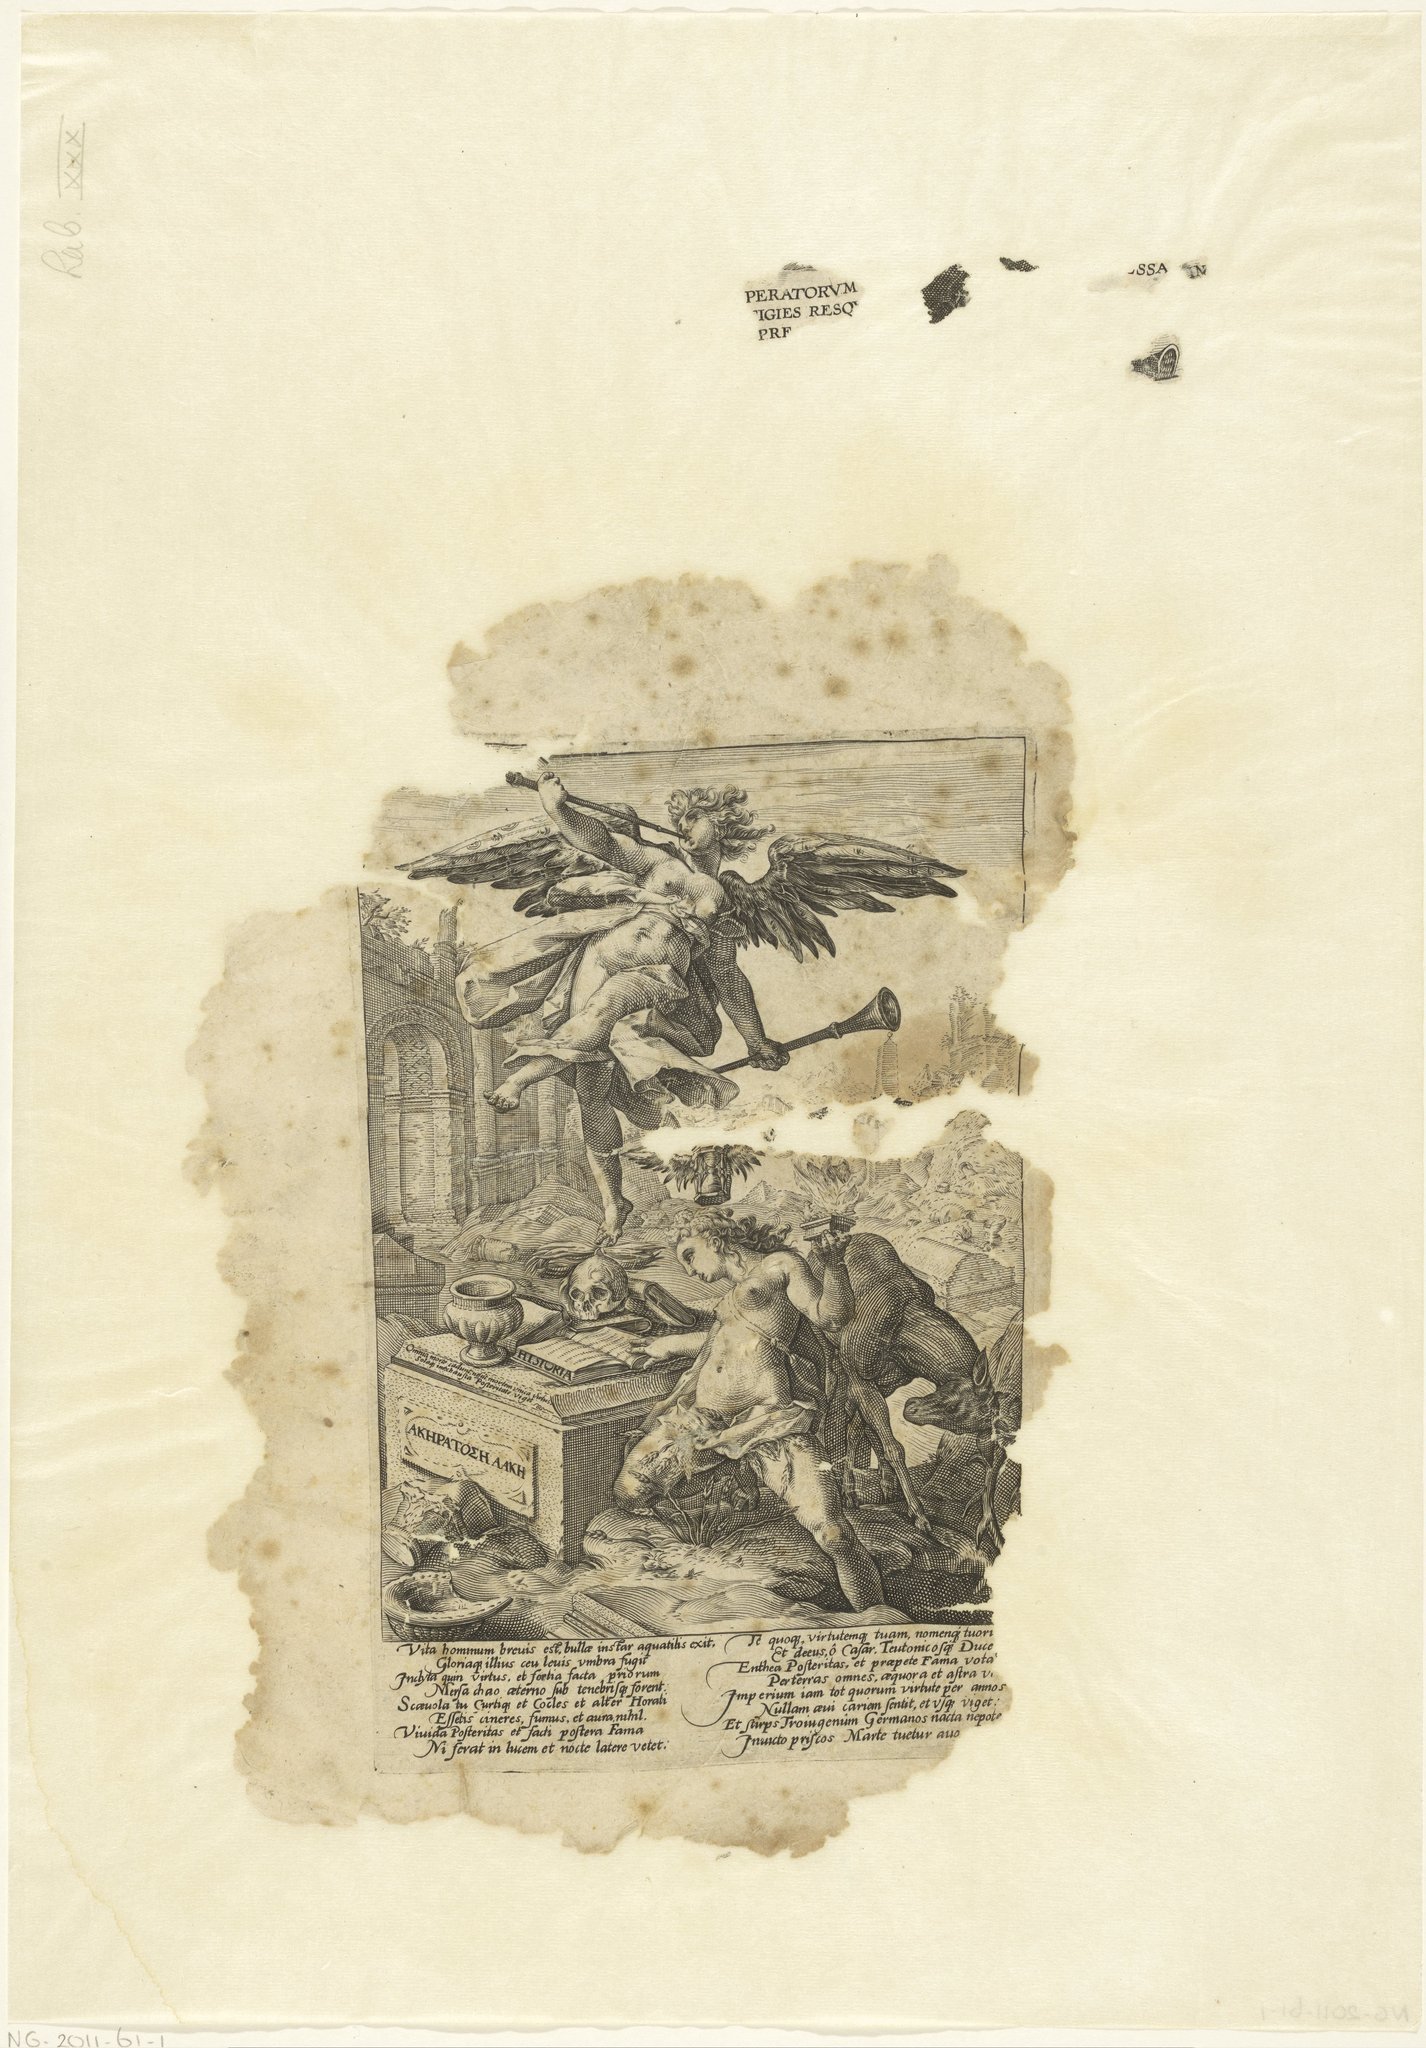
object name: print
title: Romeinse helden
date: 1586-1596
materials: paper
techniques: engraving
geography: northern netherlands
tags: 'historia'; 'historia' (ripa), fame; 'fama', 'fama buona', 'fama chiara' (ripa)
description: Deze prent is onderdeel van een serie van tien prenten, bestaand uit een ongenummerde titelprent, acht genummerde voorstellingen van helden en een ongenummerde afsluitende prent. De prenten in de Nova Zembla collectie zijn tijdens een expeditie van Willem Barendsz en Jacob van Heemskerk in 1596-1597 noodgedwongen in het winterkamp, het ‘Behouden Huis’, op het eiland achtergelaten. De prenten waren in één of meerdere stapels als handelswaar meegenomen vanuit Amsterdam. Bijna drie eeuwen later, in 1871, keerde de Noor Elling Carlsen terug naar Nova Zembla en vond daar de restanten van het ‘Behouden Huis, inclusief een groot deel van de inventaris. Een deel van de prenten, in de vorm van aaneengekoekte kluiten, werd toen ook teruggevonden. De papierkluiten waren soms op meerdere plekken gebroken. Tussen 1975-1979 zijn de prenten van elkaar gescheiden. Dit leverde in totaal ca. 1000 fragmenten van ca. 400 afdrukken van ca. 150 verschillende prenten op. Voor zover mogelijk zijn de fragmenten samengevoegd en zijn de prenten gereconstrueerd.